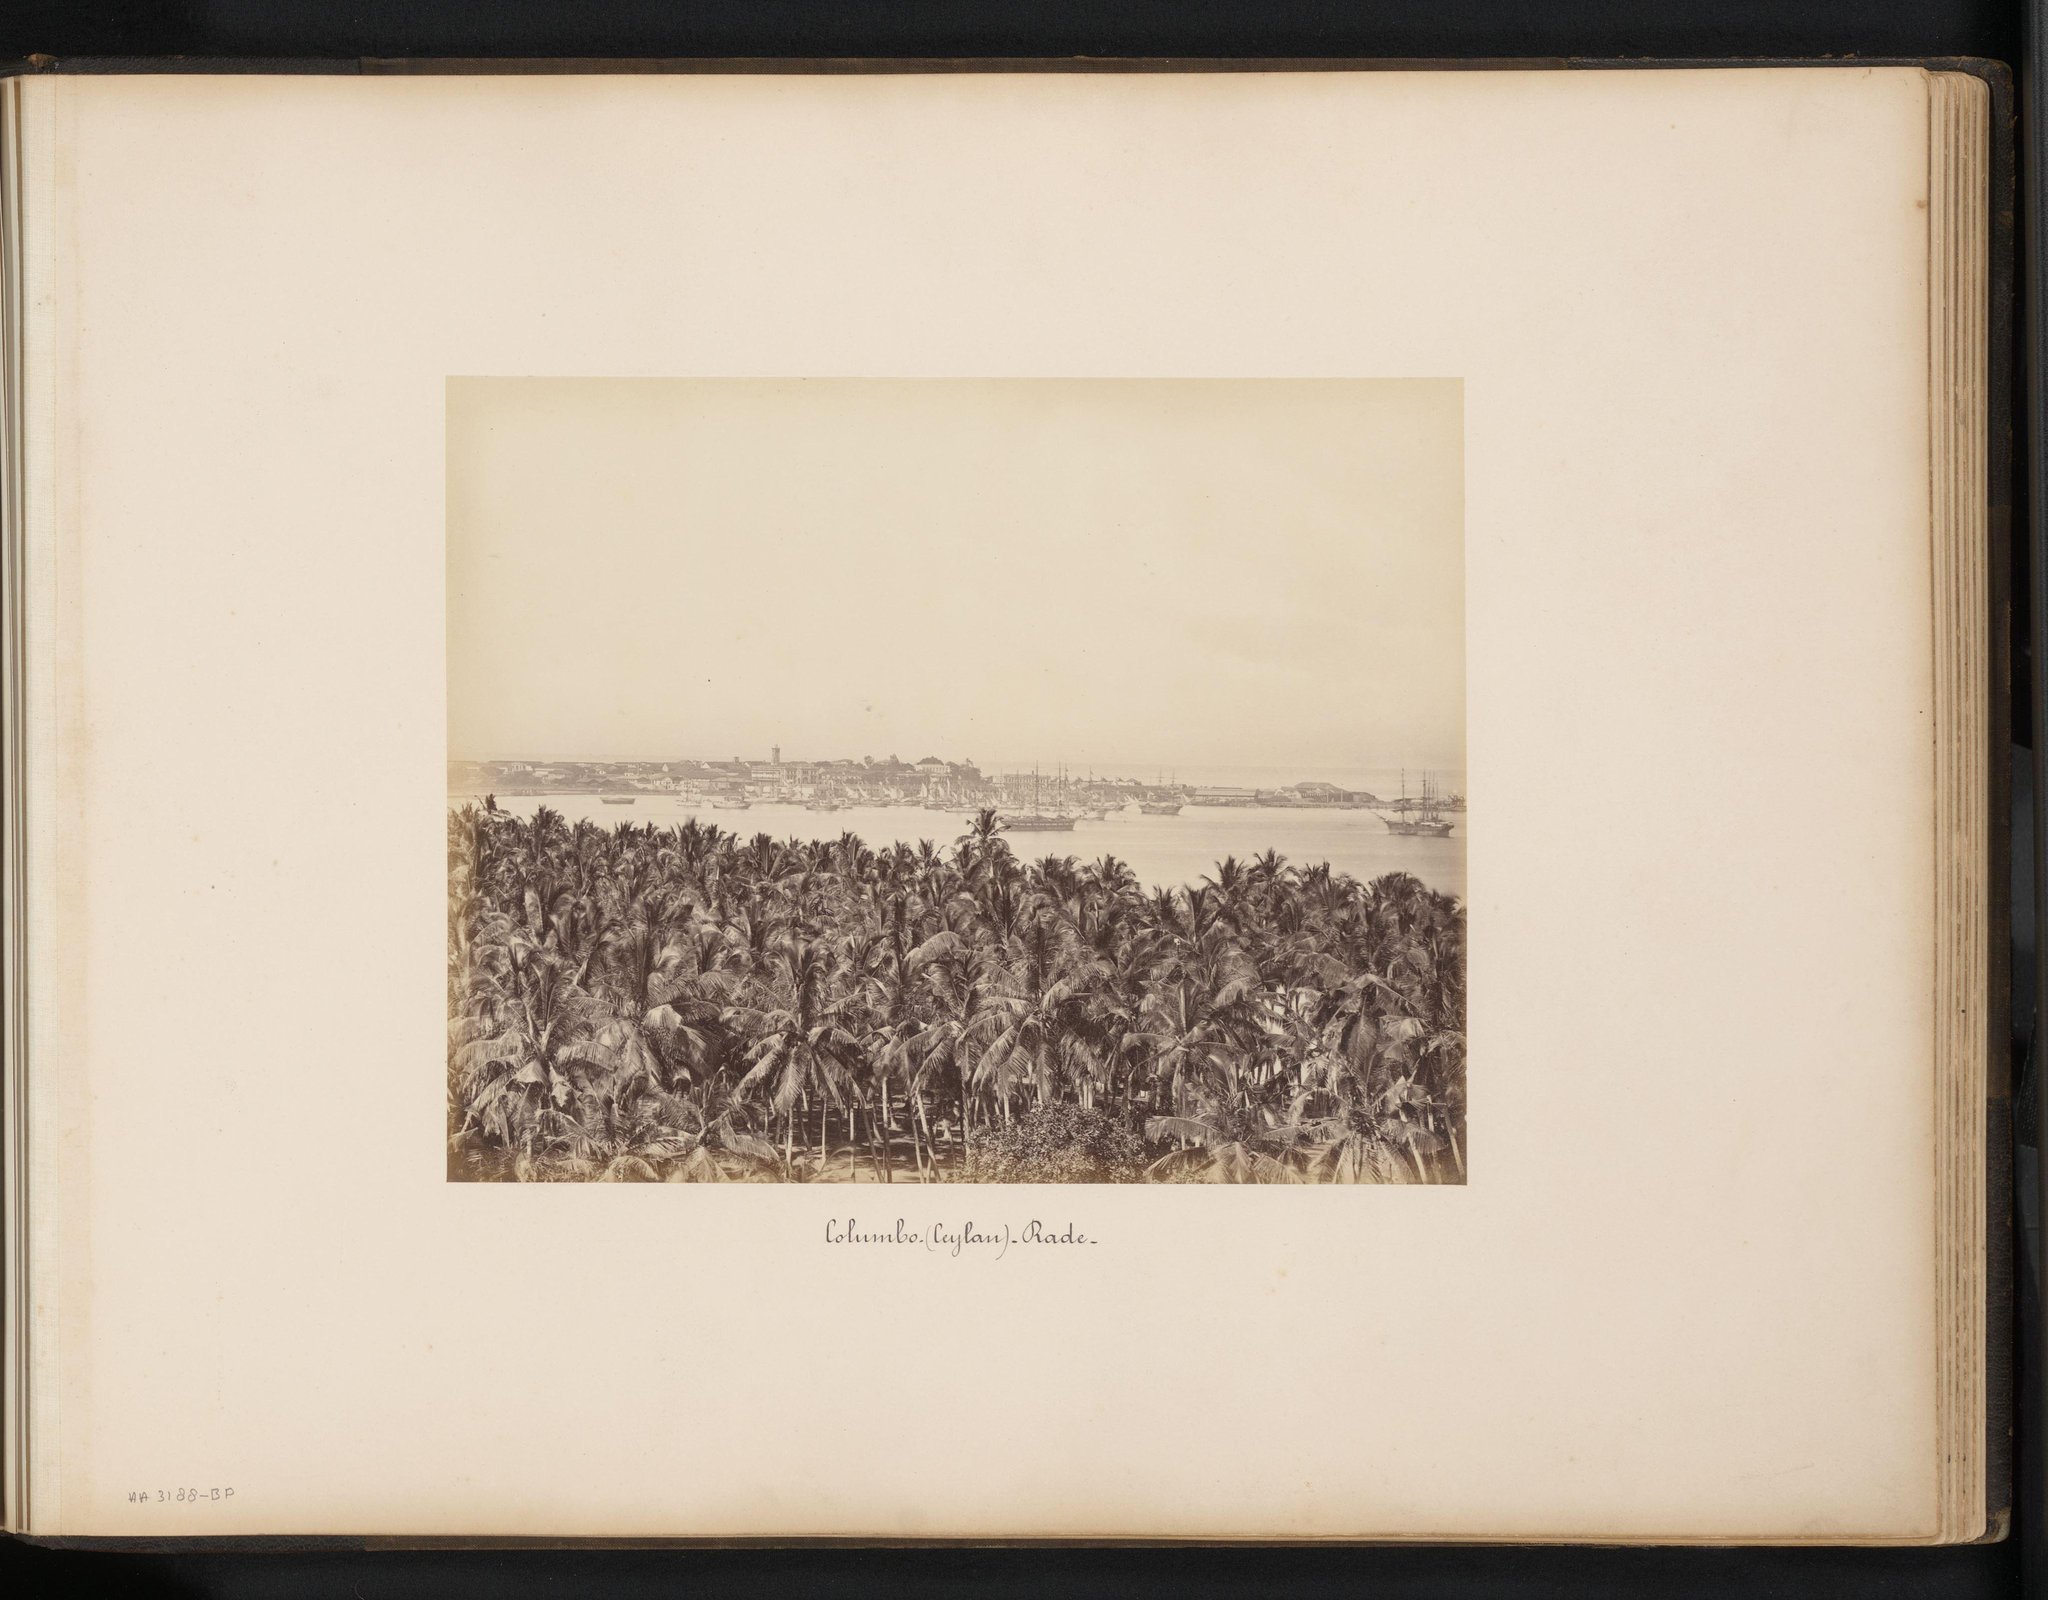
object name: photograph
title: View of the roadstead of Colombo, Sri Lanka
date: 1880-1883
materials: photographic support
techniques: albumen print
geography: colombo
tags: harbour (+ view ~ vehicle, ship, etc.)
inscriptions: inscription: ‘Photographers/ W.L.H. Skeen & Co./ Colombo. Ceylon’, title: ‘Columbo. (Ceylan) _ Rade _’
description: Onderdeel van Reisalbum met opnames van bezienswaardigheden in Egypte, Nederlands-Indië, Singapore en Ceylon.